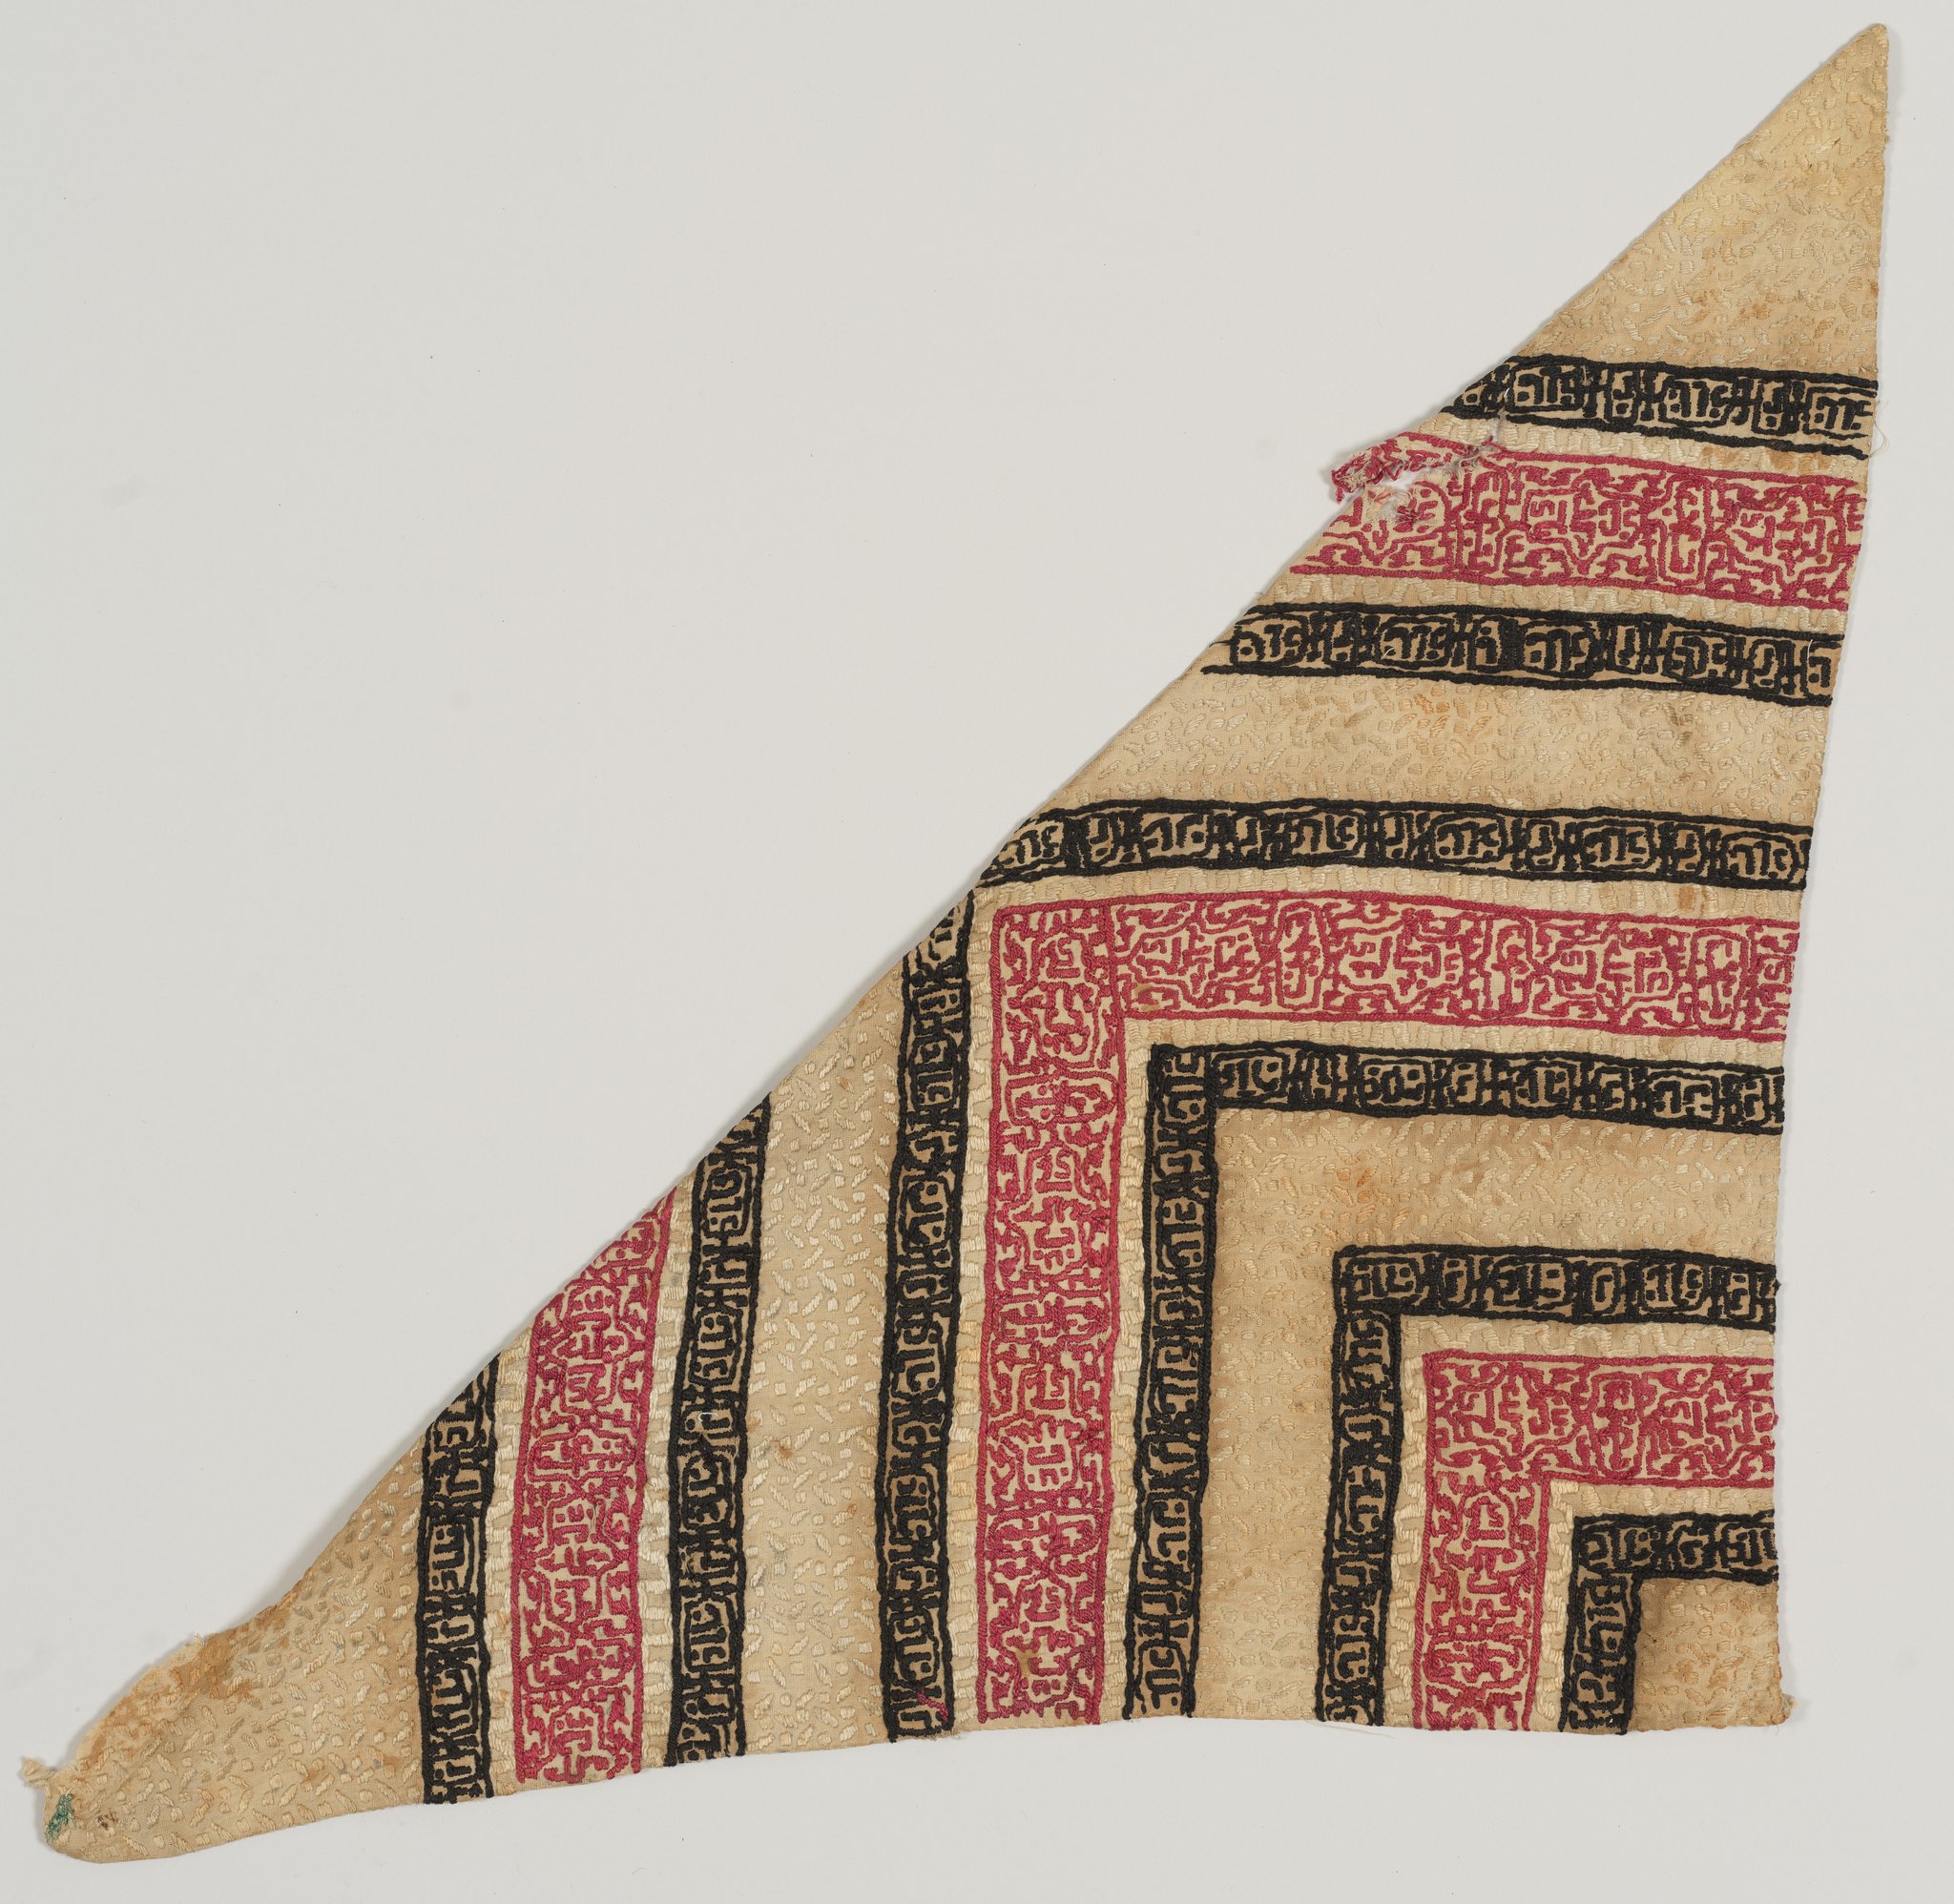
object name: textile fragment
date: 1801-1900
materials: linen, silk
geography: algeria